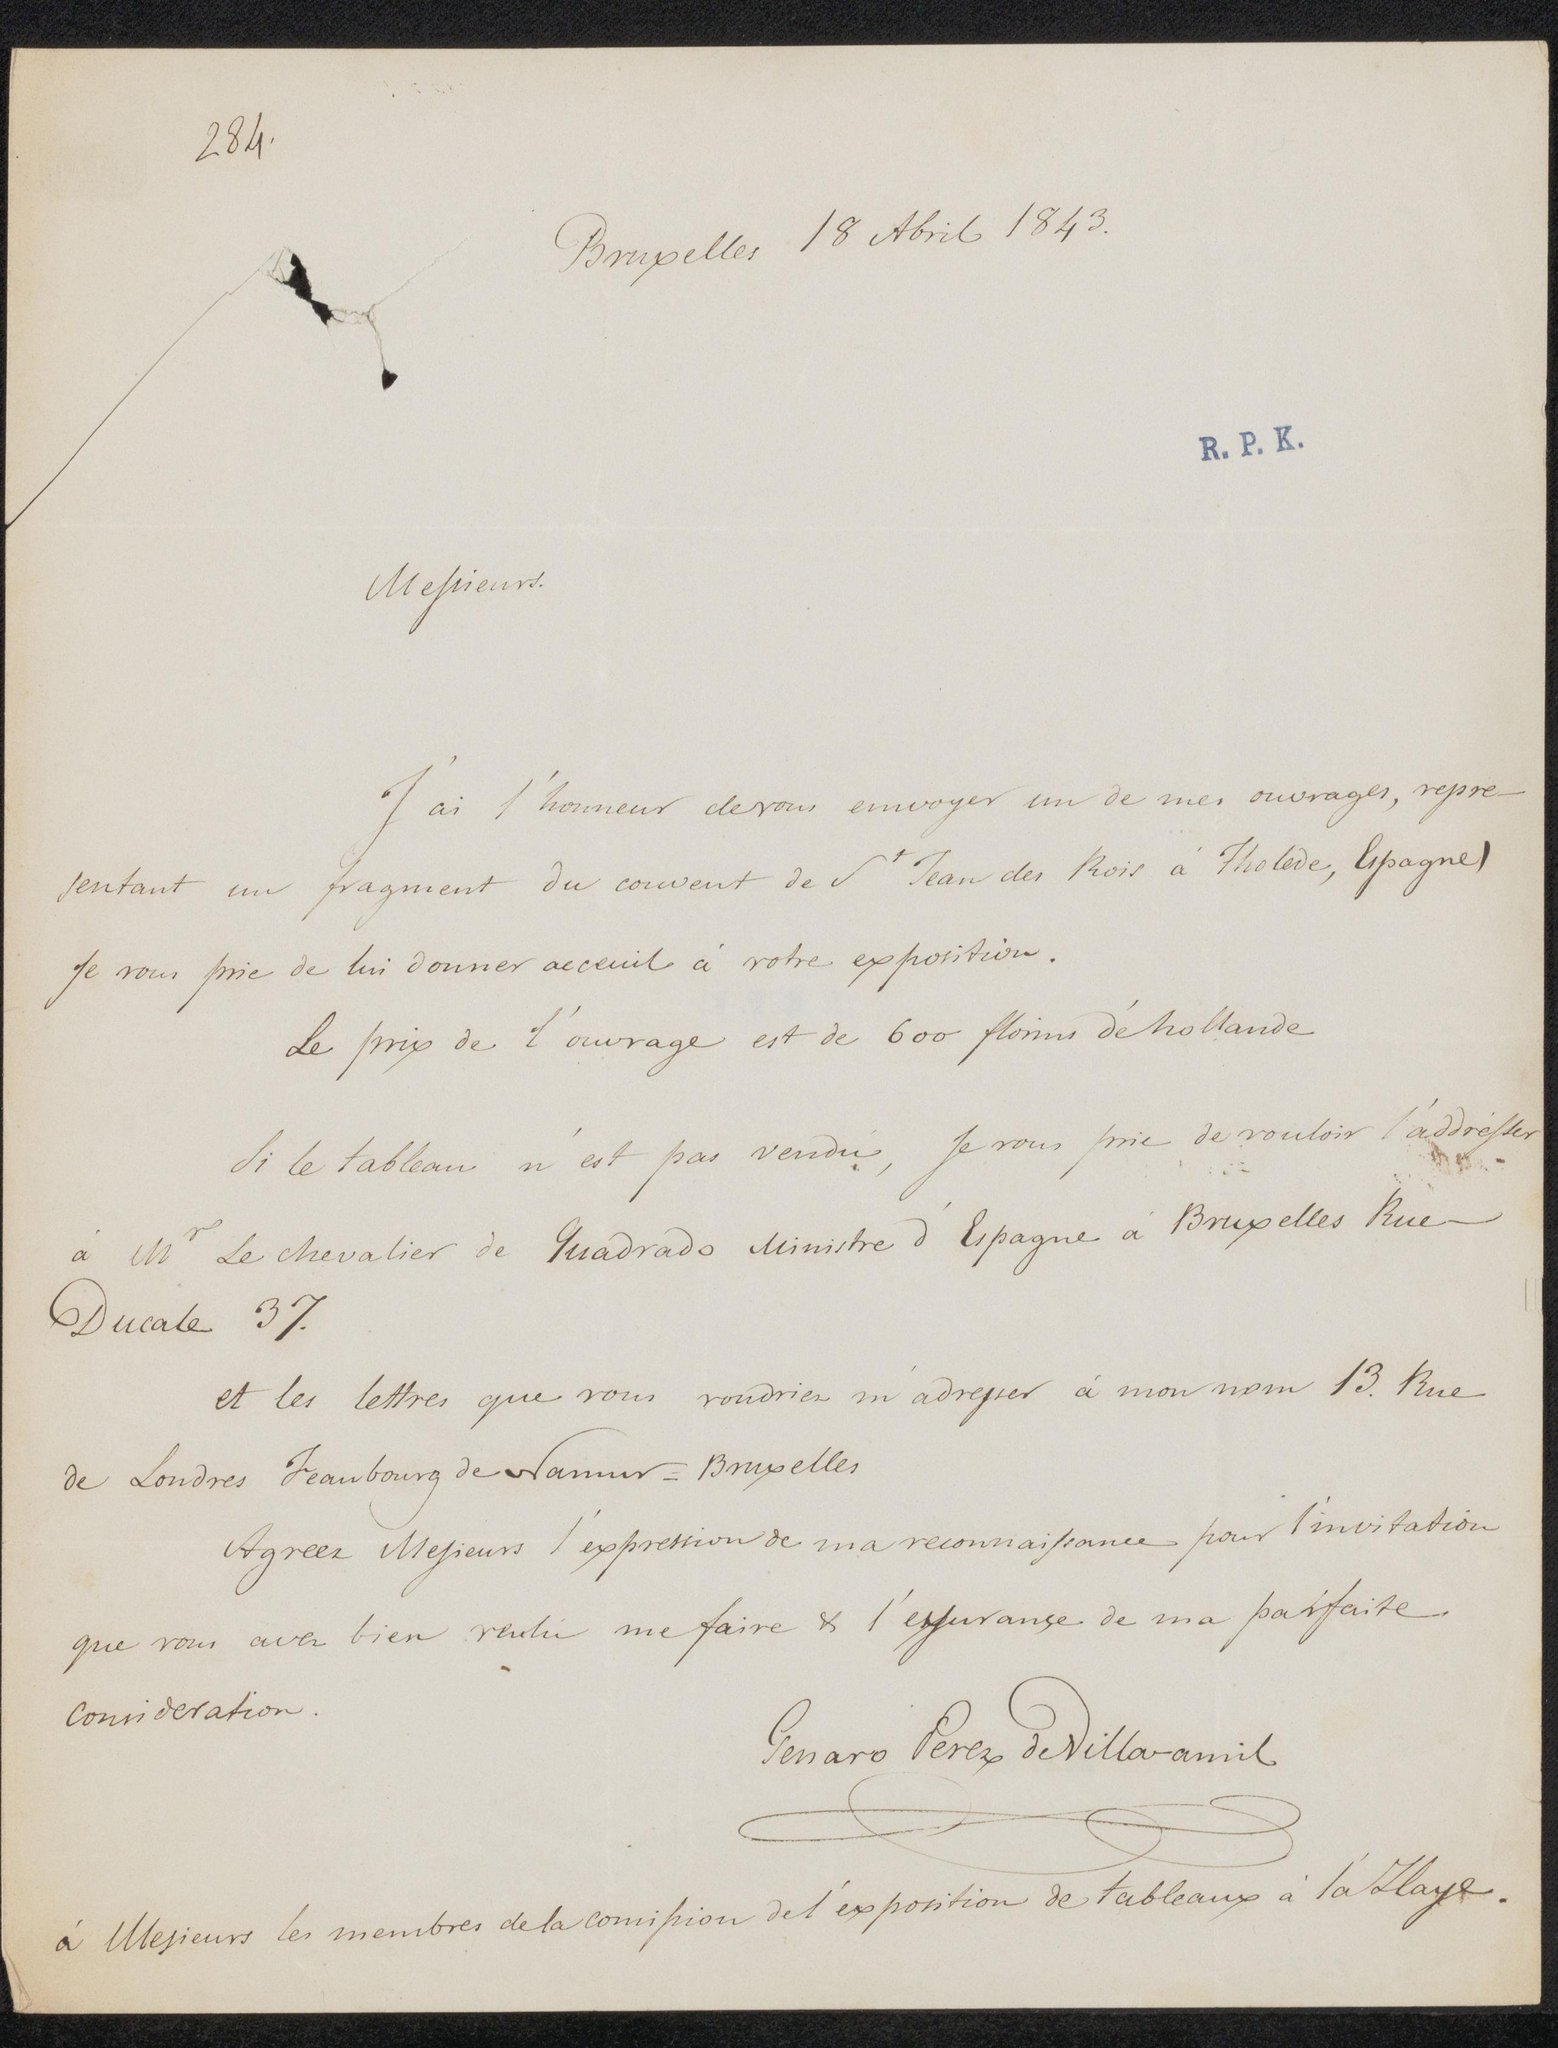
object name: letter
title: Brief aan de commissie van de Tentoonstelling van Levende Meesters in Den Haag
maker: genaro de perez de villovamil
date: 1843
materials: ink, paper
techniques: pen, writing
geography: brussels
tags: painting (including book-illumination, miniature-painting), exhibition ~ art, money, brussels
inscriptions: collector's mark: Lugt 2233